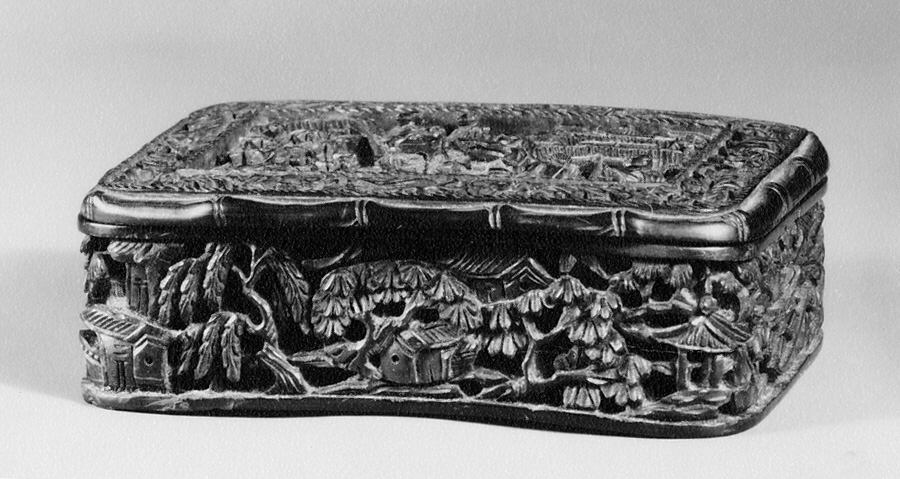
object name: box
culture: chinese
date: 1644-1911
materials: shell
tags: houses,trees